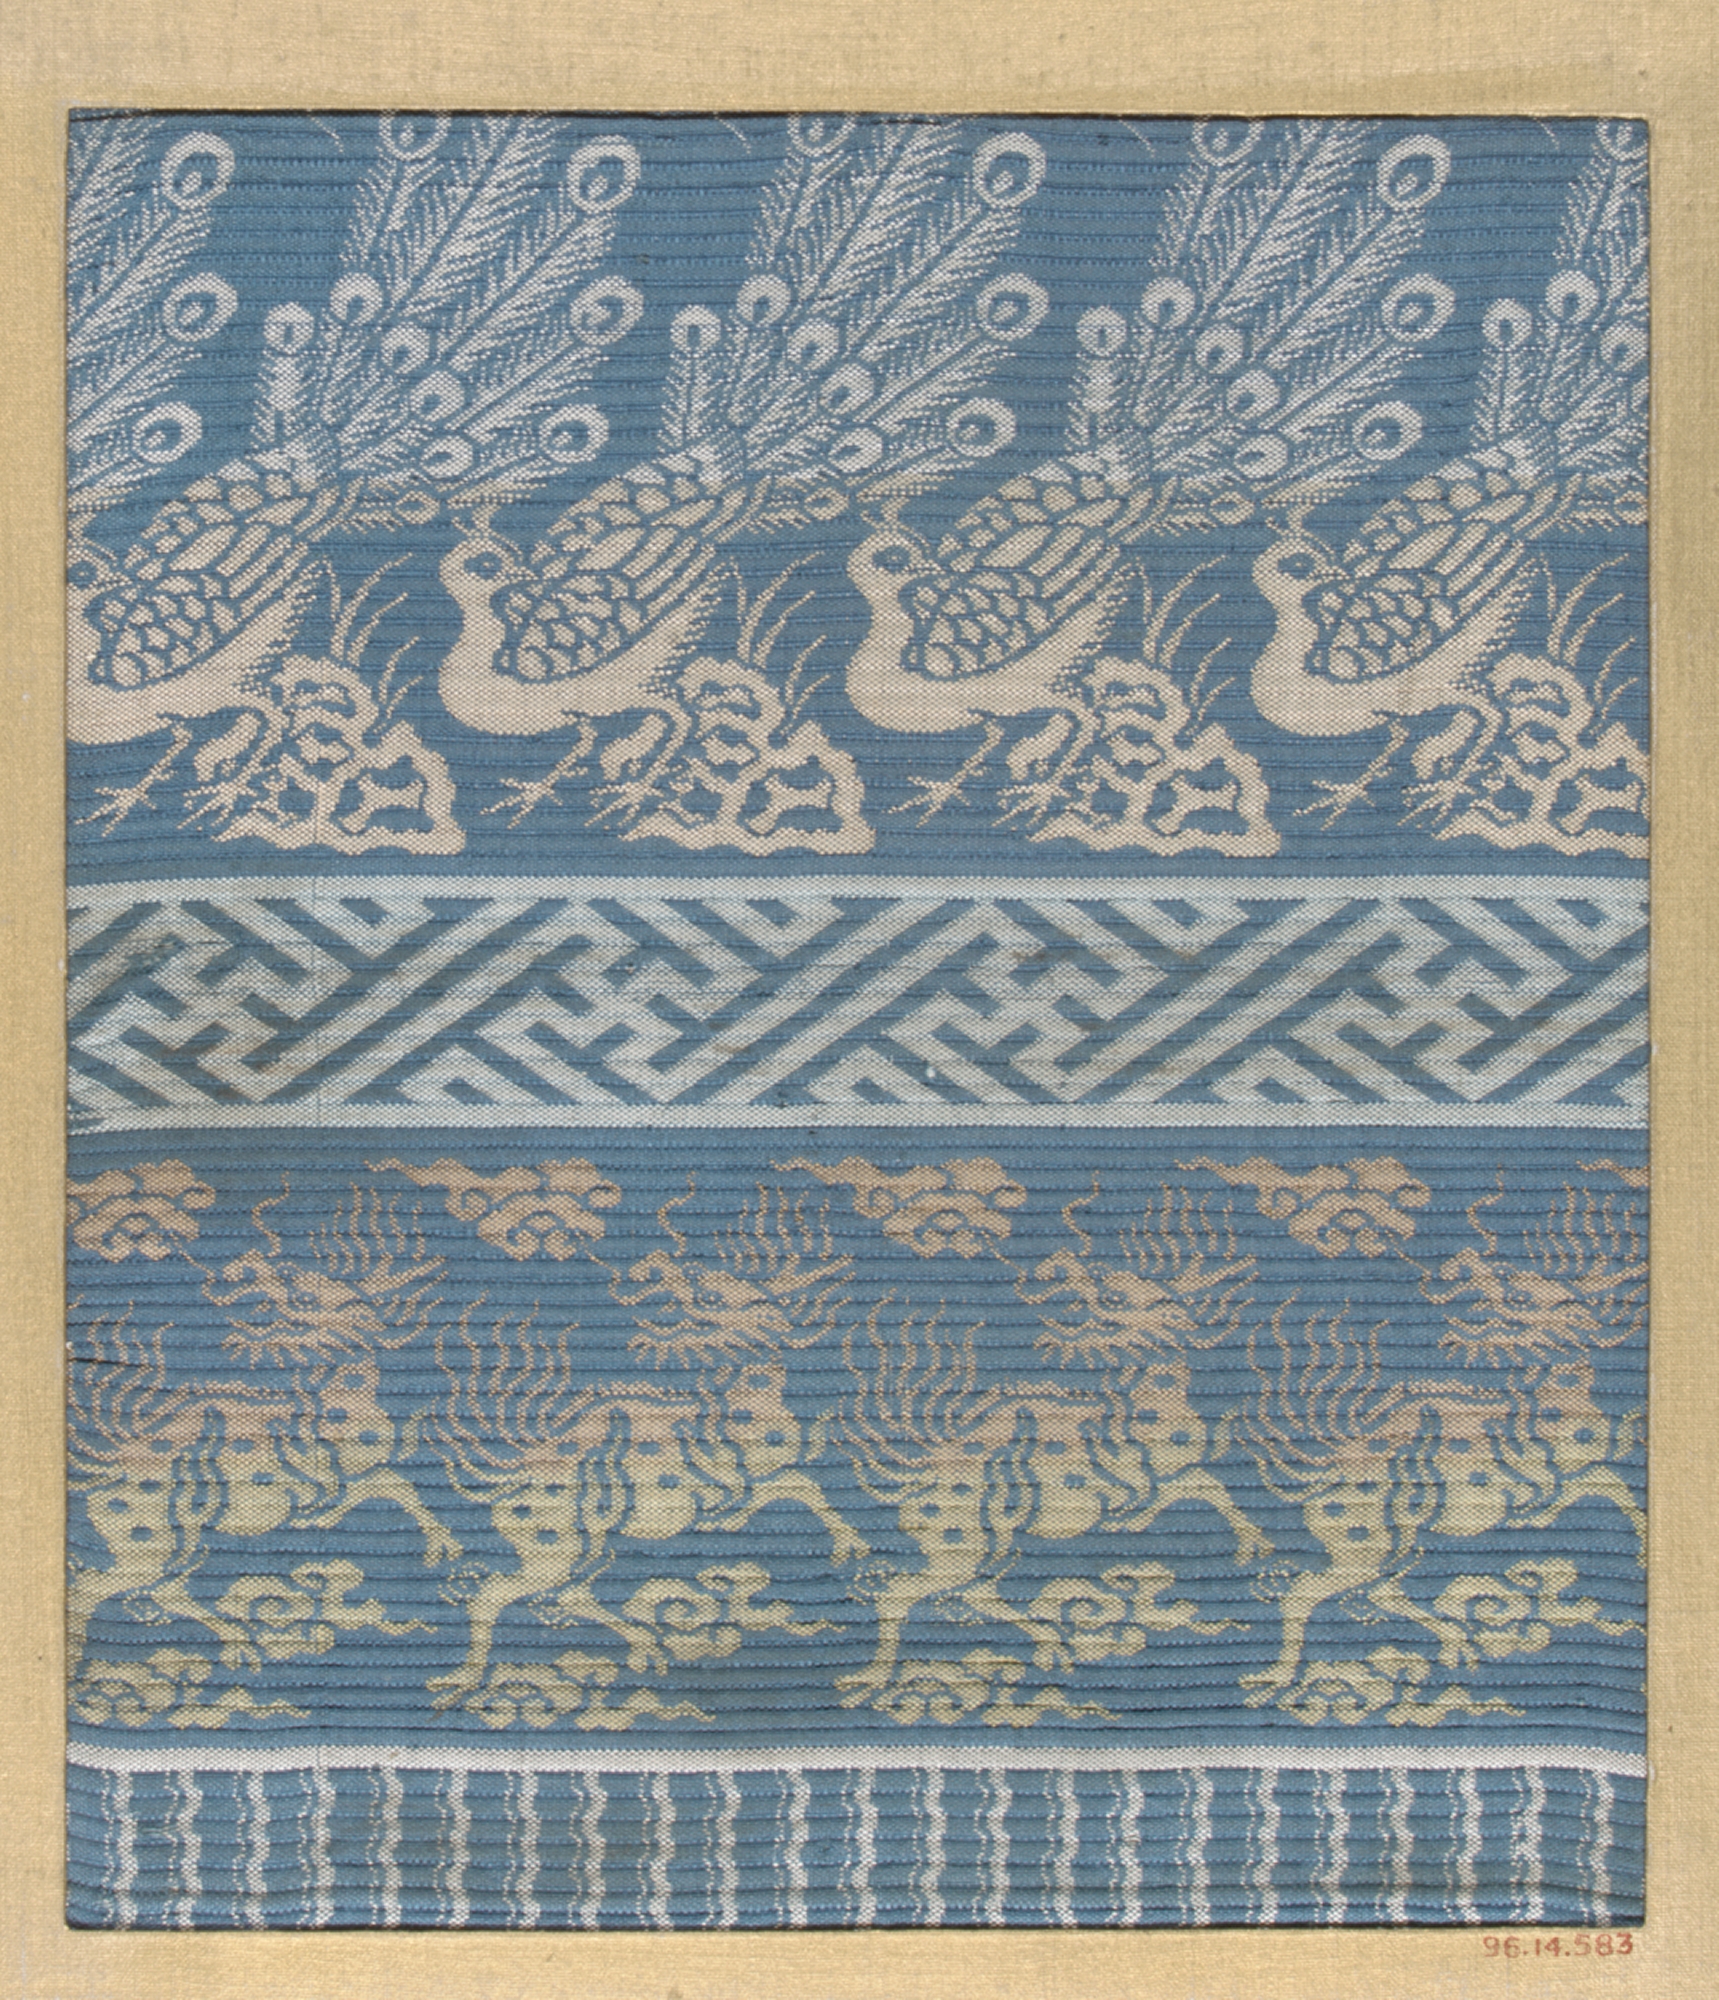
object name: piece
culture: japanese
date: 1701-1900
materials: silk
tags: peacocks